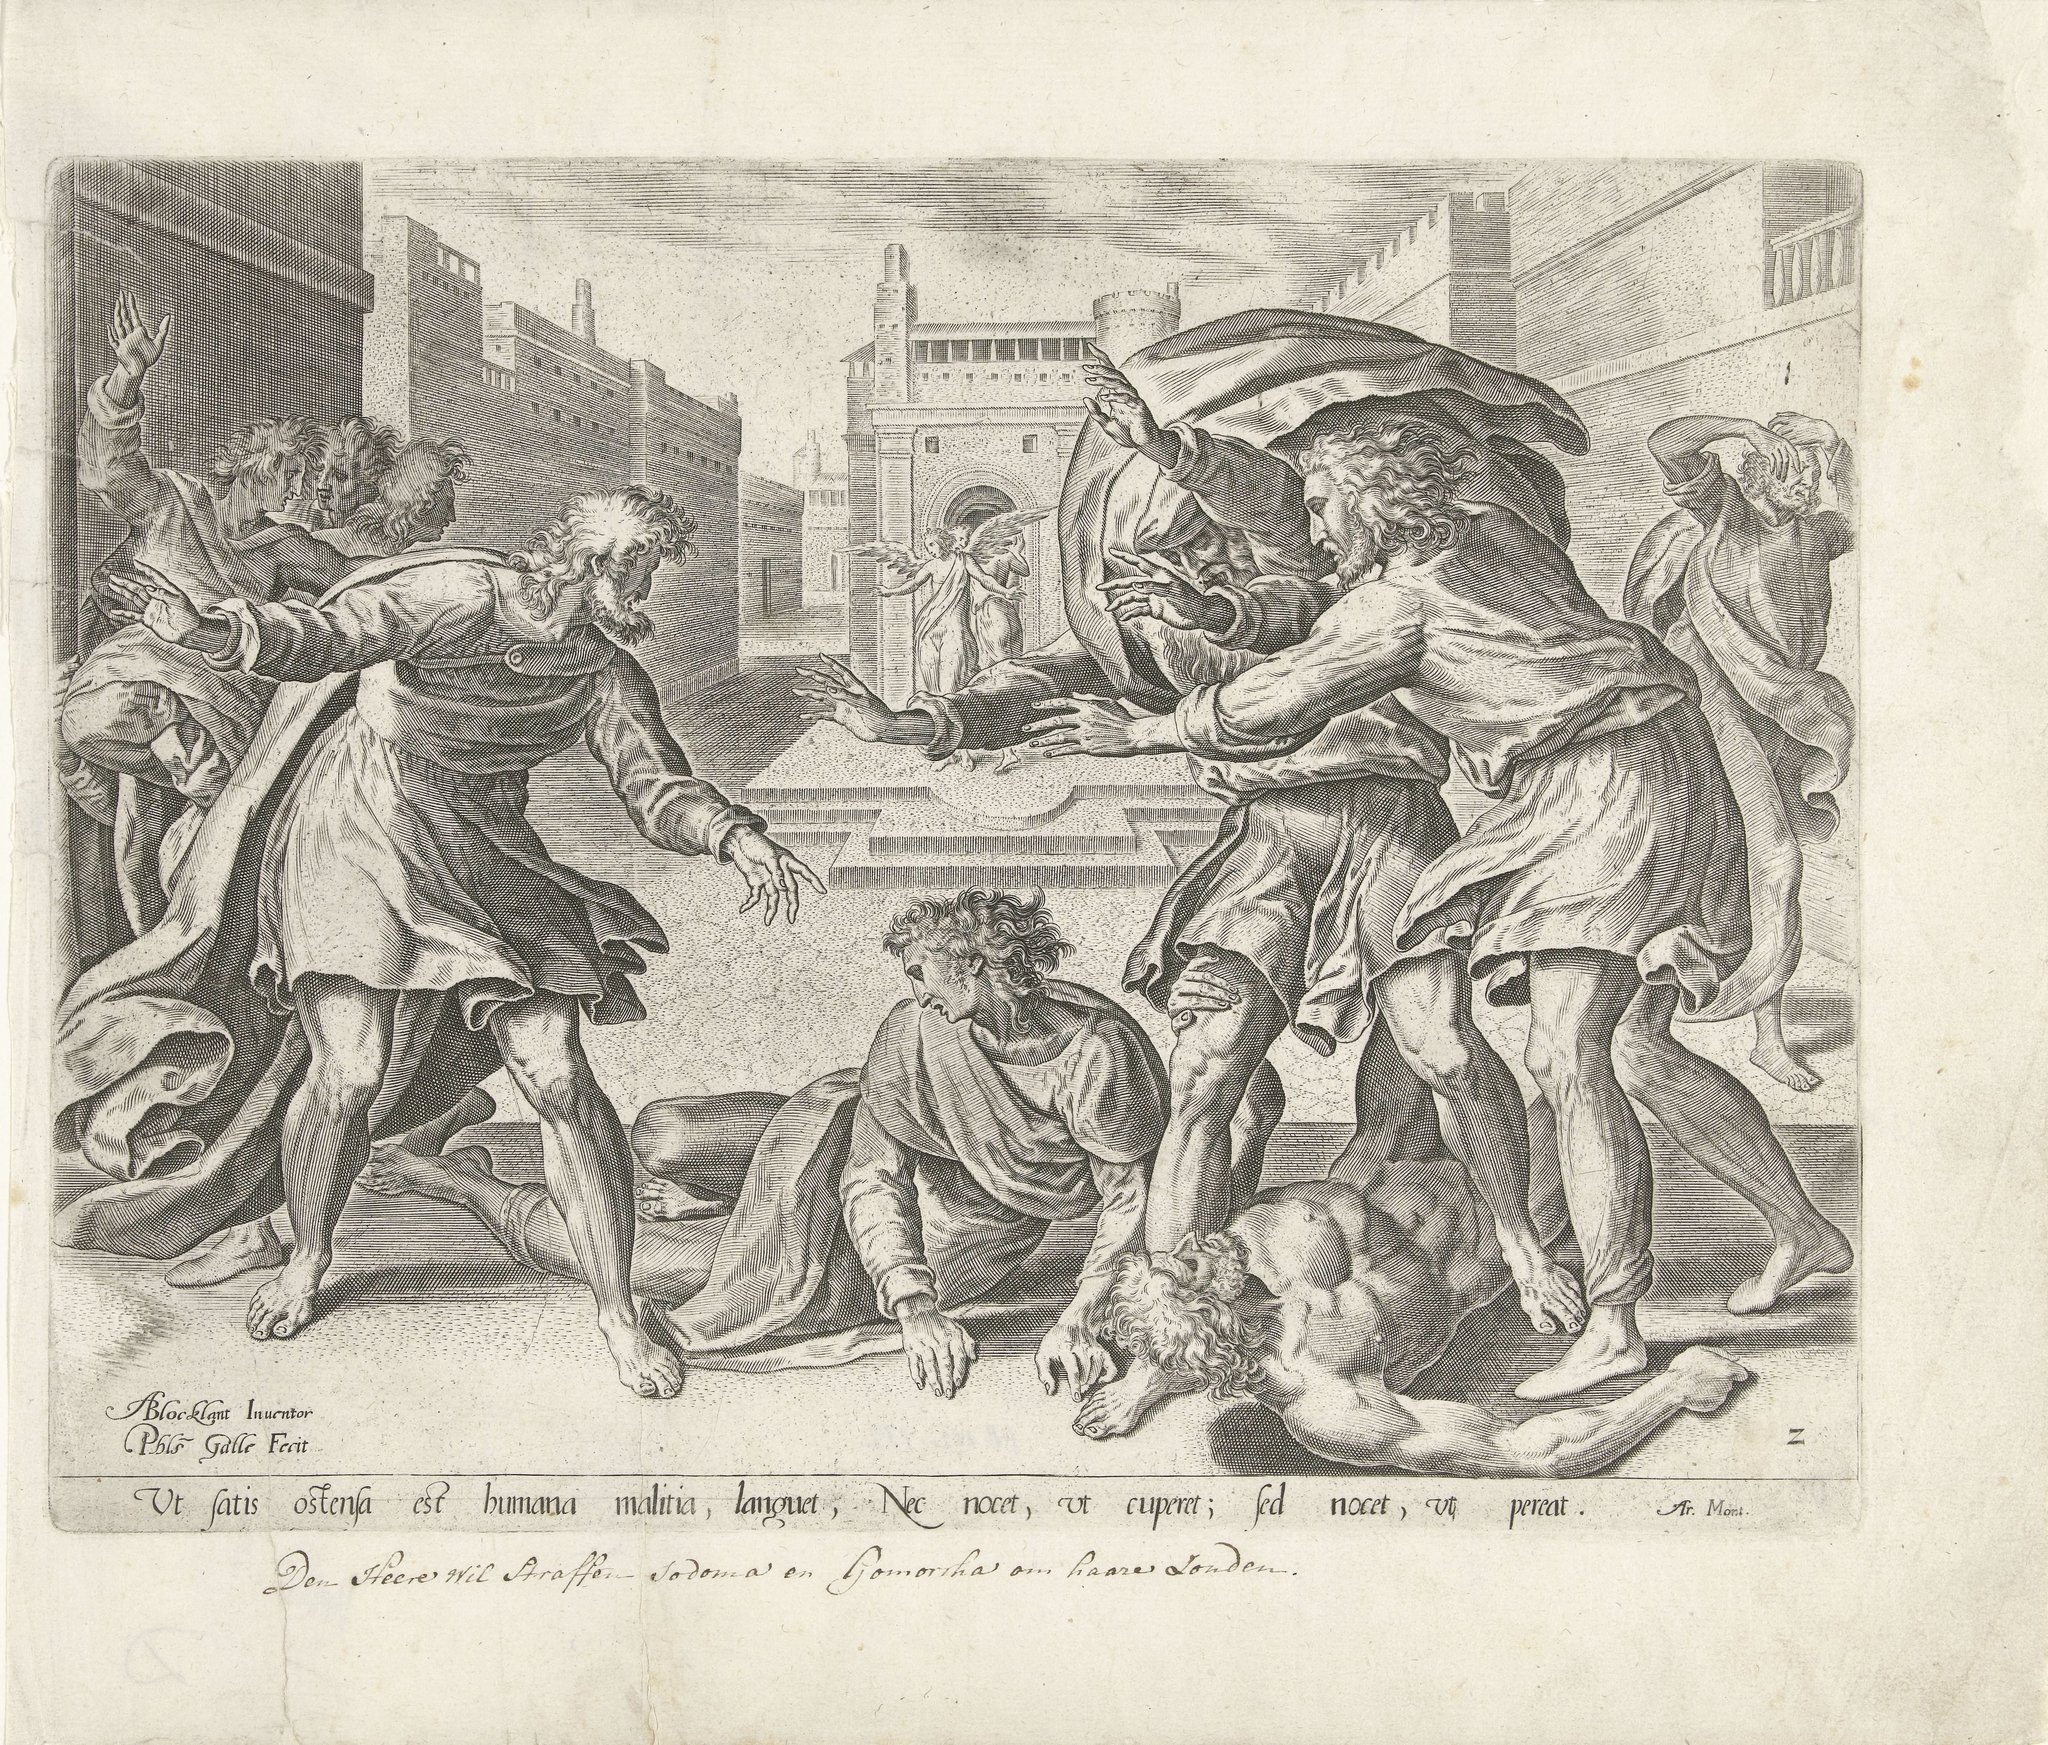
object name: print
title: De mannen van Sodom met blindheid geslagen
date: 1557-1570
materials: paper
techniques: engraving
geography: haarlem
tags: the two angels intervene and strike the mob that surround lot's house with blindness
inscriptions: collector's mark: Lugt 2228, inscription: ‘Den Heere wil straffen Sodoms en Gomorrha om haare sonden.’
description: De mannen die bij het huis van Lot zijn verzameld worden door God met blindheid geslagen. Twee van hen liggen op de grond. Op de achtergrond de twee engelen voor het huis van Lot.